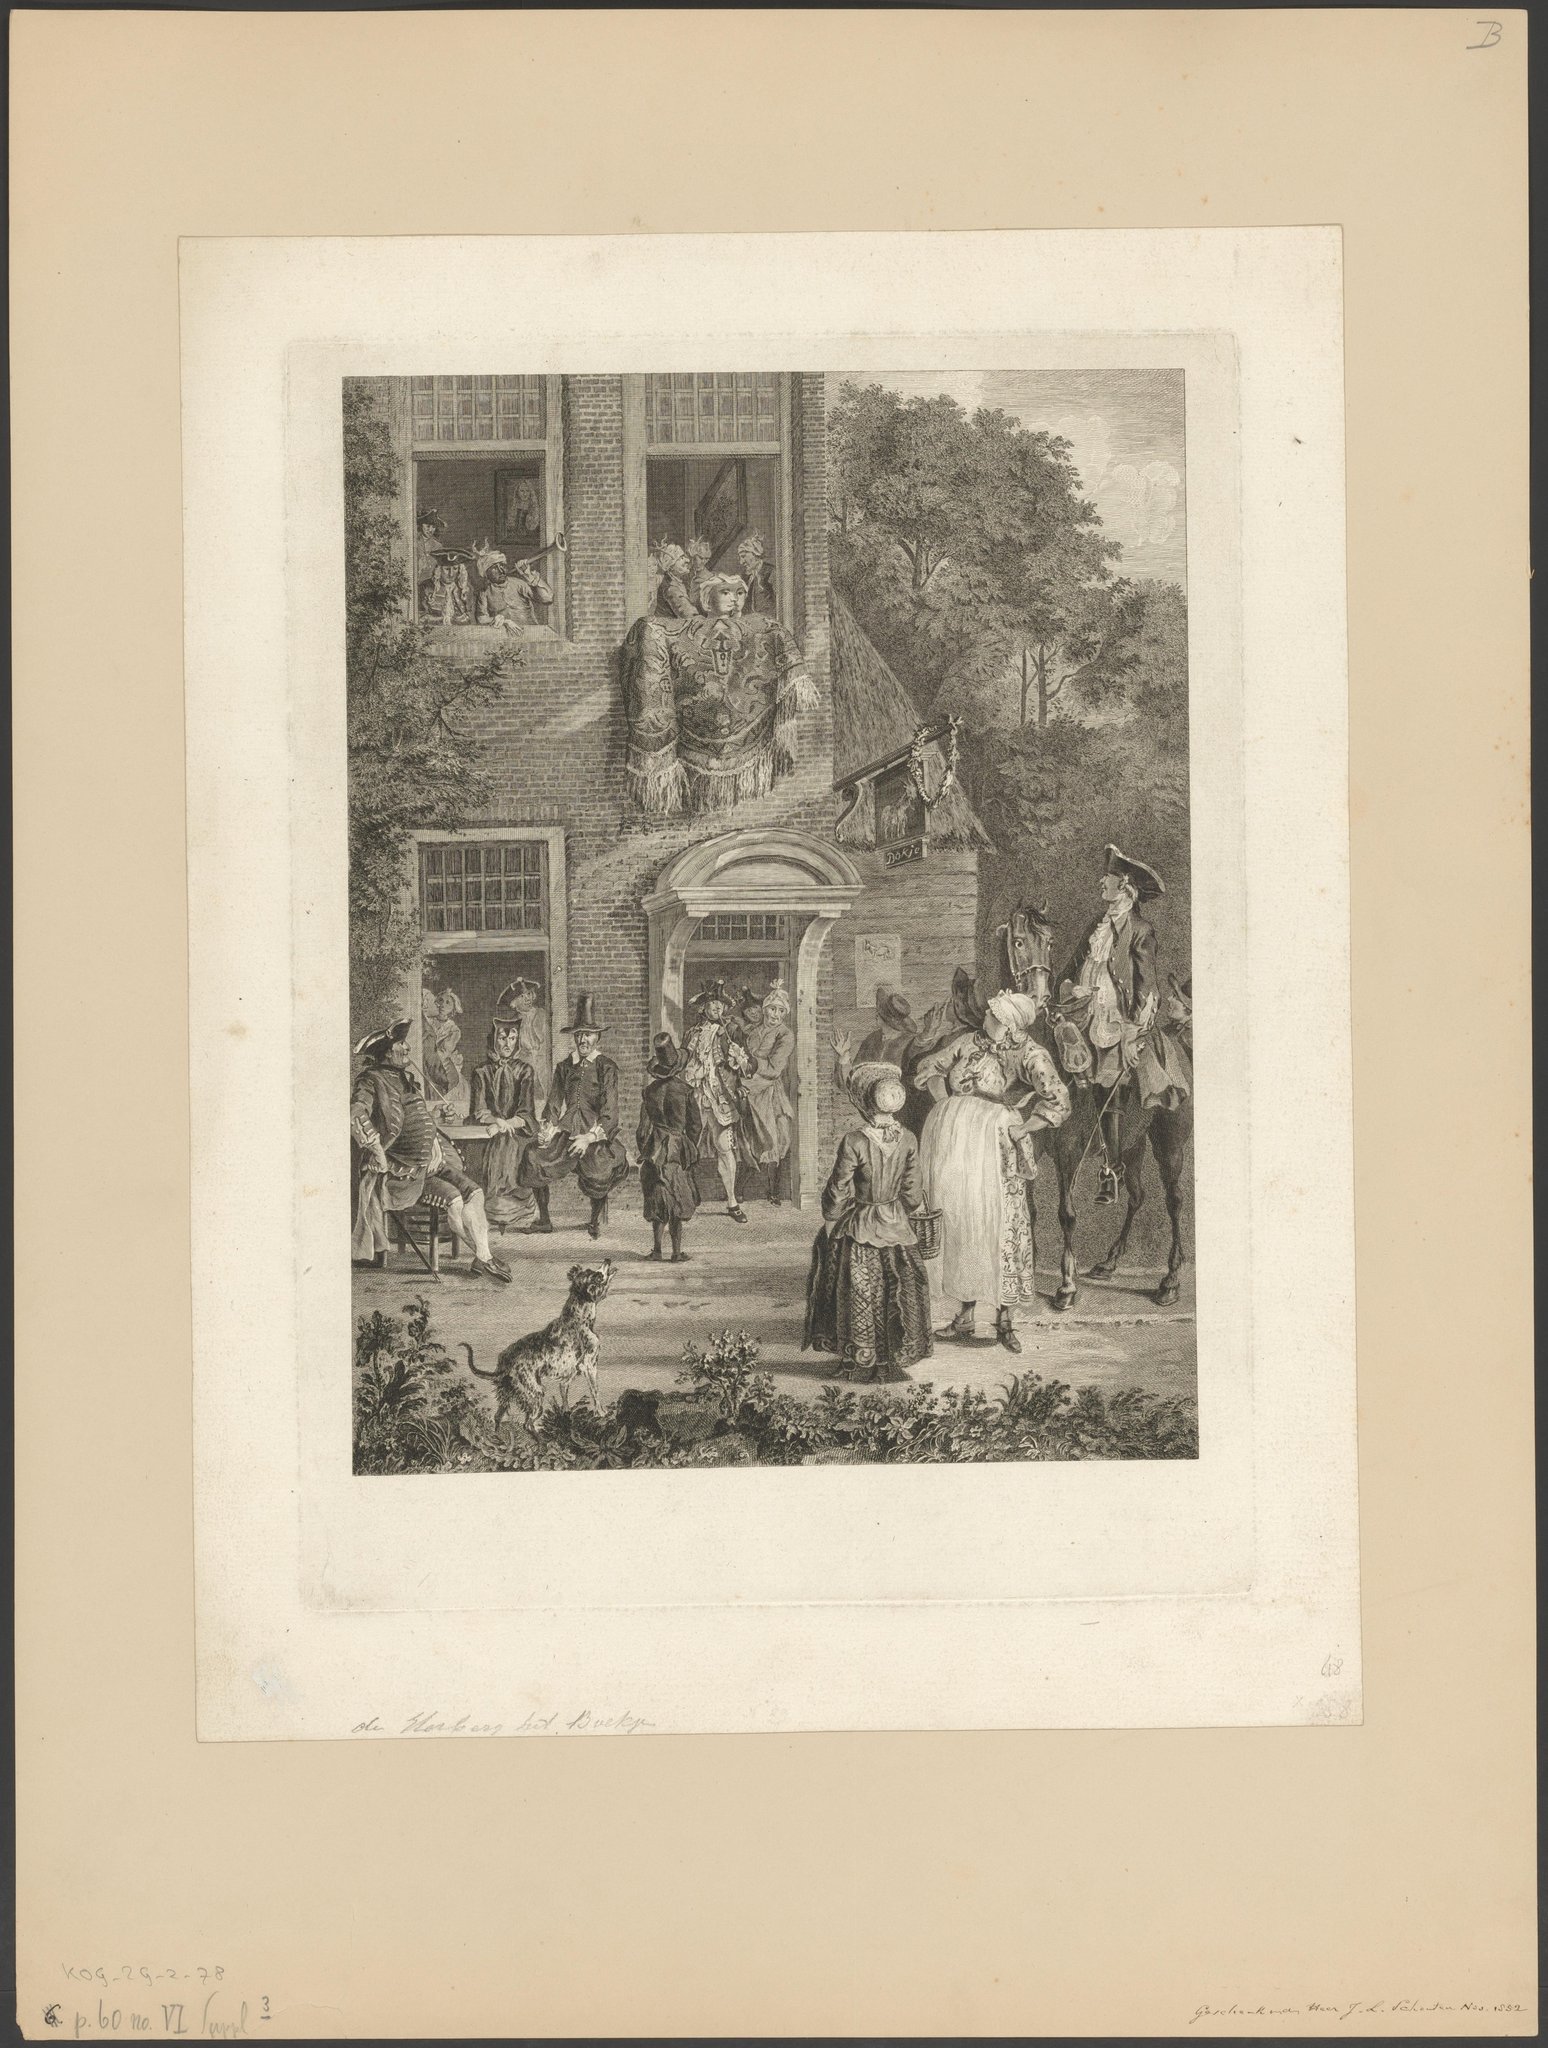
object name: print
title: De Ambassadeur van de Laberlotten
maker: jean pelletier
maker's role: print maker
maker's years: 1736-1780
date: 1755-1765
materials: paper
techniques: engraving, etching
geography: amsterdam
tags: amsterdam, painter, draughtsman, cornelis troost, protestant churches and denominations, pavement, terrace in front of inn or restaurant, buttocks, 'partes posteriores', painting of body or face, hotel, hostelry, inn, comedy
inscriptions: collector's mark: Lugt 2488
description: De ambassadeur der Labberlotten vertoont zich voor het venster van de herberg 't Bokki ('t Bokje) in de Haarlemmerhout. Mogelijk een grap bedreven door Jacob Campo Weyerman en consorten in 1739, mogelijk een grap van de waardin om meer bezoekers te trekken. Een groep mensen kijkt naar het als een gezicht beschilderde achterwerk, uit het venster van de herberg gestoken. In de venster ernaast een trompetter met zwart geverfde gezicht. Links aan een tafel zit de schilder, Cornelis Troost, zelf. Staat vóór de letter.